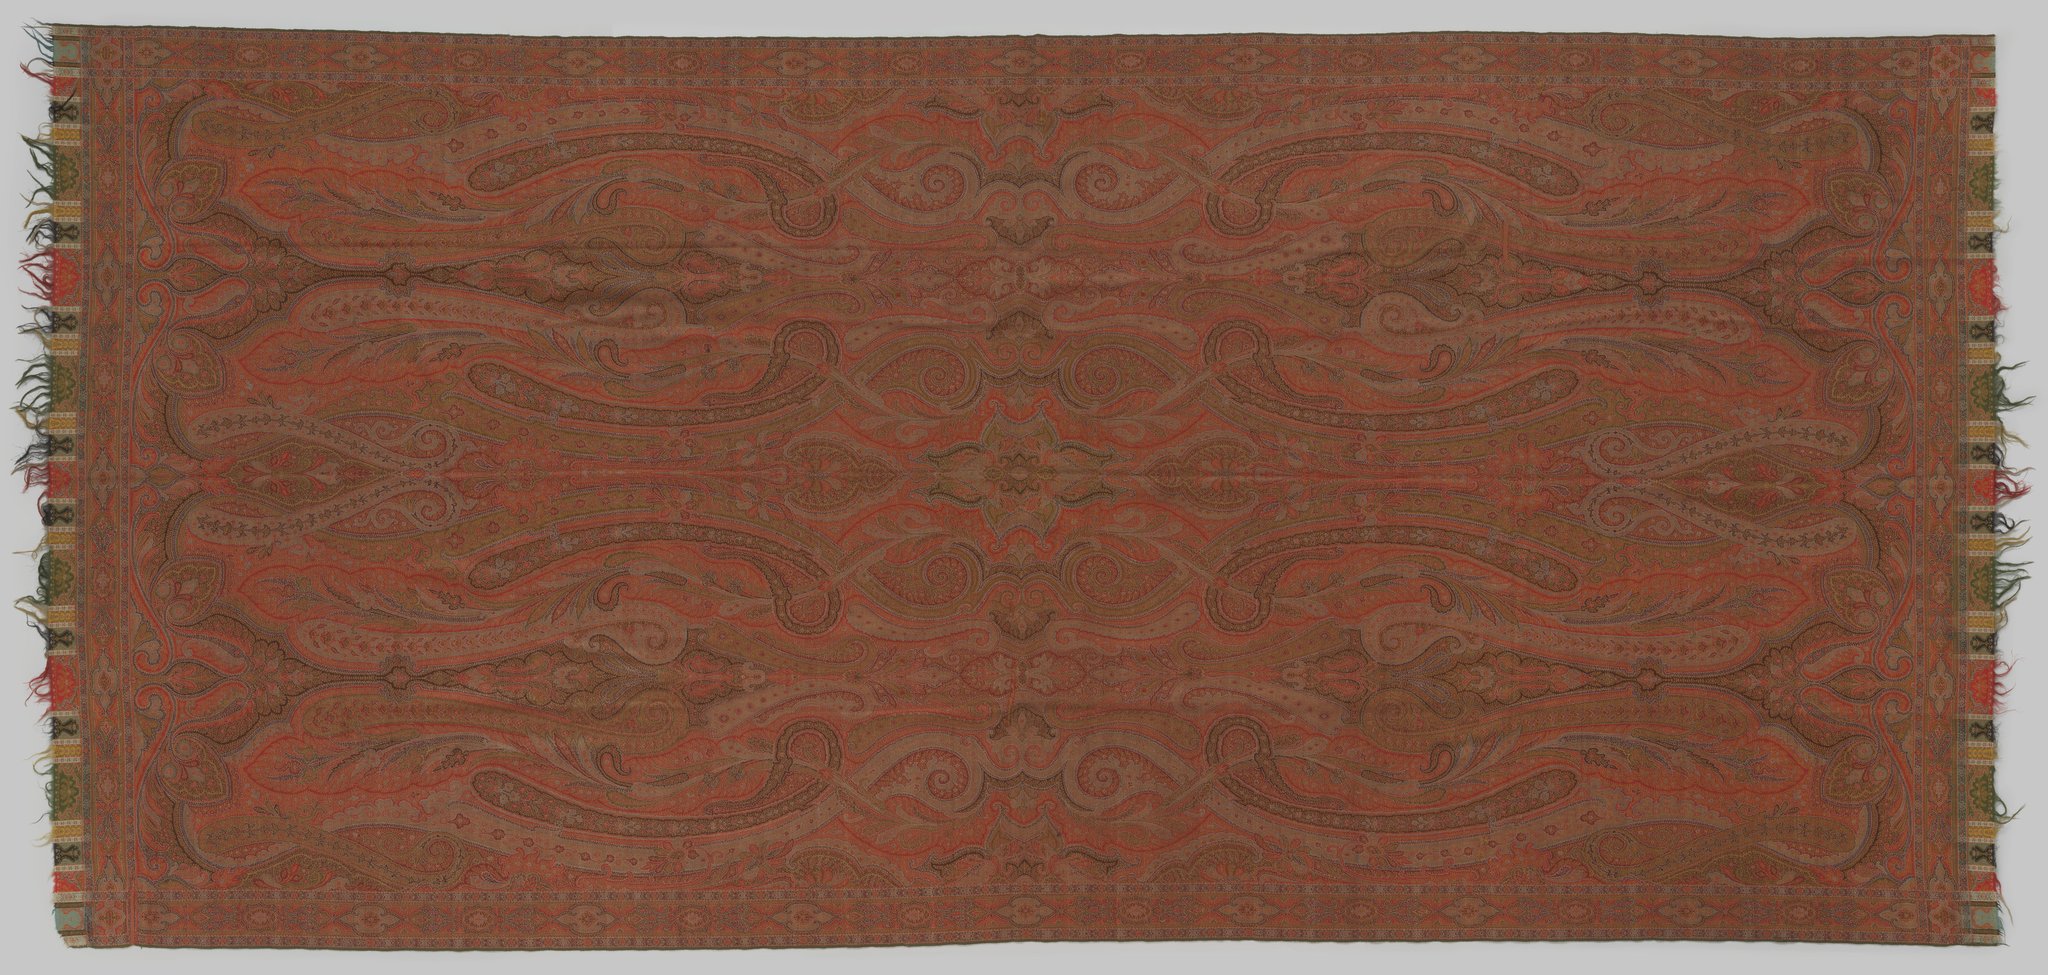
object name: scarf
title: Langwerpige kasjmiersjaal volledig bedekt met een patroon van langerekte veermotieven en bloemen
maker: Anonymous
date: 1851-1865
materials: wool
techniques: weave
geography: western europe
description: Palmenshawl, of 'worteldoek', van geweven wol, langwerpig met een vol patroon van langgerekte bots's, in rood, licht blauw , wit, geel, groen en zwart en met de dwarsrandnen verdubbeld met een poortjesrand. Techniek. Een rode ketting is met kleurige inslagen in een keperbinding van 1:3 geweven. Waat de effen poortjes beginnen is de kleur van de ketting gewijzigd; misschien door het verven op te gespannen ketting(?) anders door een rode en een anders gekleurde elkaar een eindje te laten overlappen. Patroon. Symmetrisch dessin om de kruisassen. In het midden staat een in de lengte gerekte achtpuntige cartouche met spitsovaal hart en twee binnenwaartse palmetten, op een gerekt en rood omlijnd veld. Vier toegewende en de halve shawllengte beslaande groene bots's sluiten met hun voluten tegen de middencartouche aan. Zij woorden in de voet door twee afgewende lichtblauwe bota's oversneden en zij gaan bovenaan vergezeld van zwarte en lichtblauwe dito's. Vanuit de voluut van de groene bota's hangen, ook over de halve lengte, gevederde bladtakken in alle kleuren neer. Het halve middenpatroon herhaaldt zich aan de linker en rechterzijde, maar nu in afwisselende kleuren. Rand: Opzij en onderaan loopt een smalle cartouche-rand, vermeerderd onderaan met een smalle poortjesrand, in rood, groen, l.blauw, geel en wit.